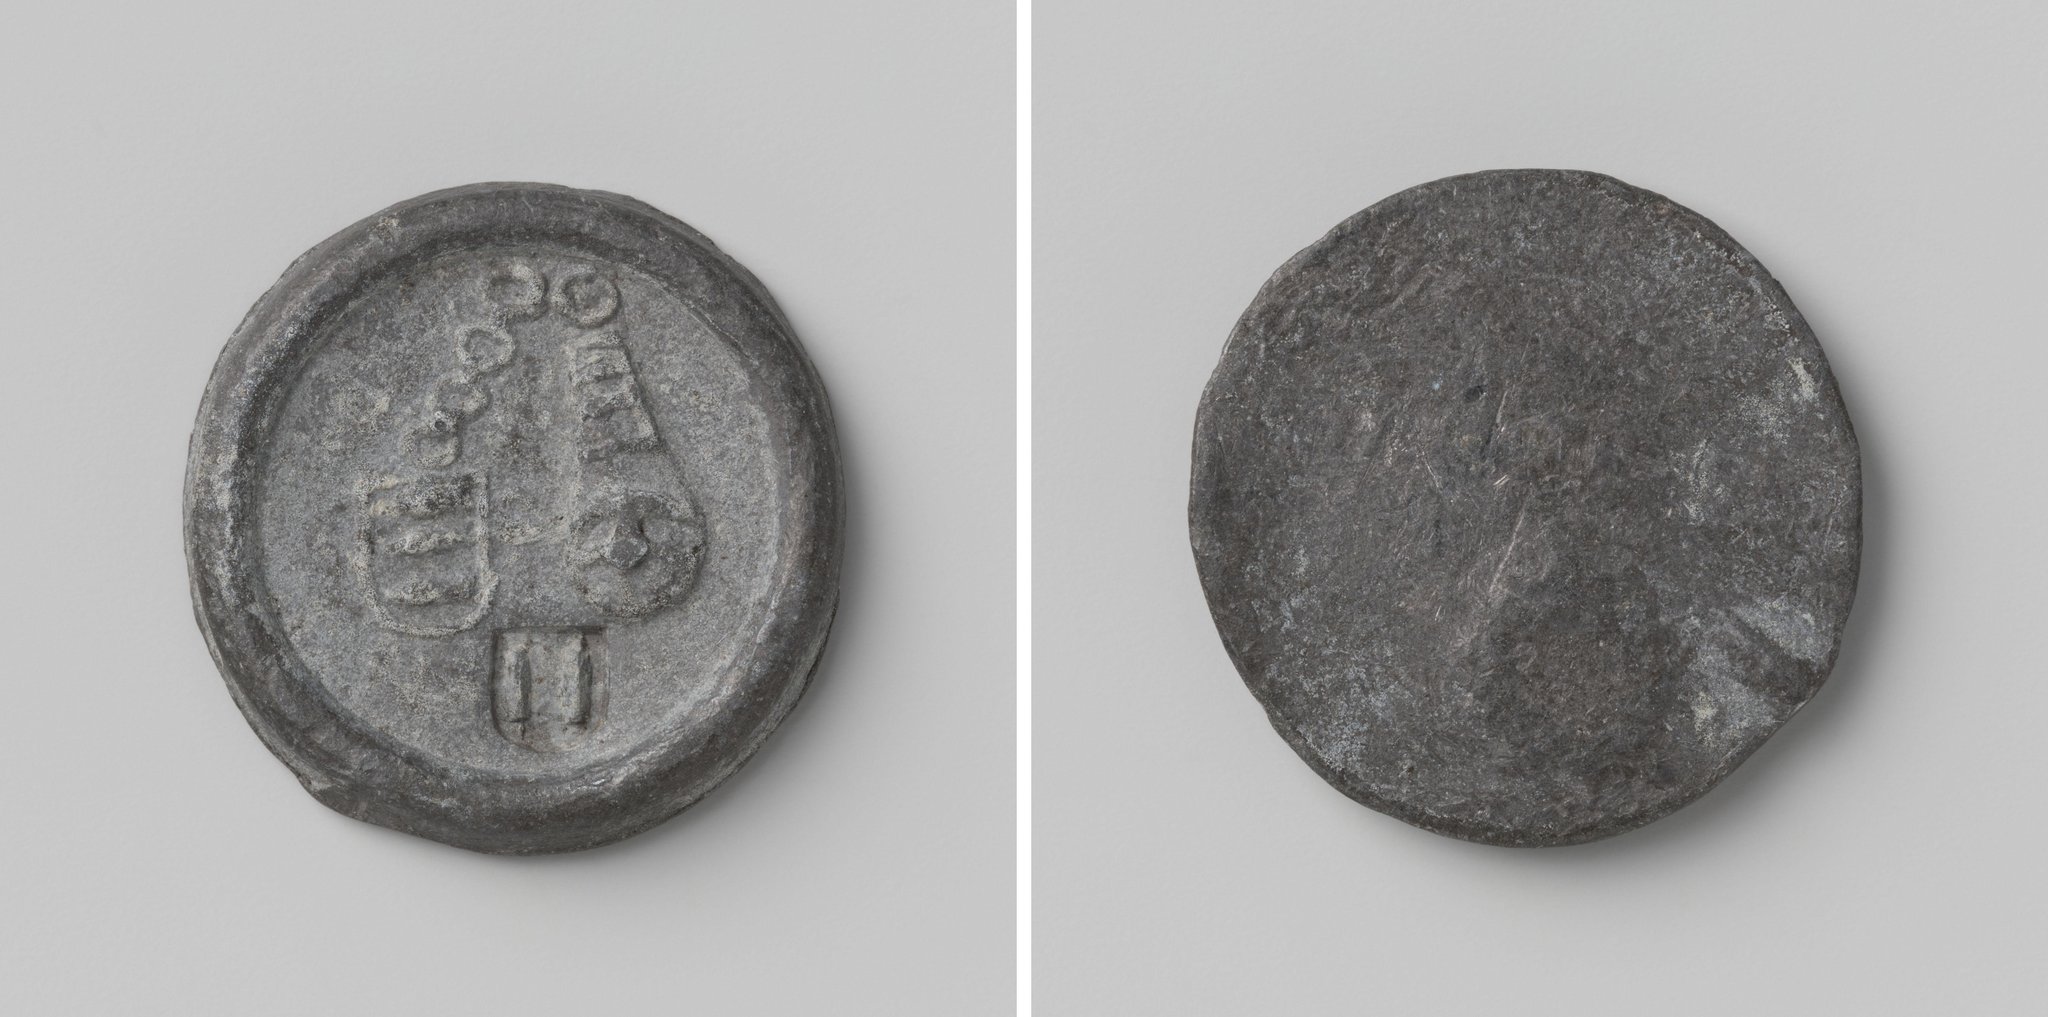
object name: tonnegeld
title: Stad Enkhuizen, loodje met cijfer 11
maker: Anonymous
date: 1600-1800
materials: lead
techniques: striking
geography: enkhuizen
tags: enkhuizen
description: eenzijdig loodje. Voorzijde: stempel en wapenschild boven compartiment met cijfer 11. Keerzijde: blanco